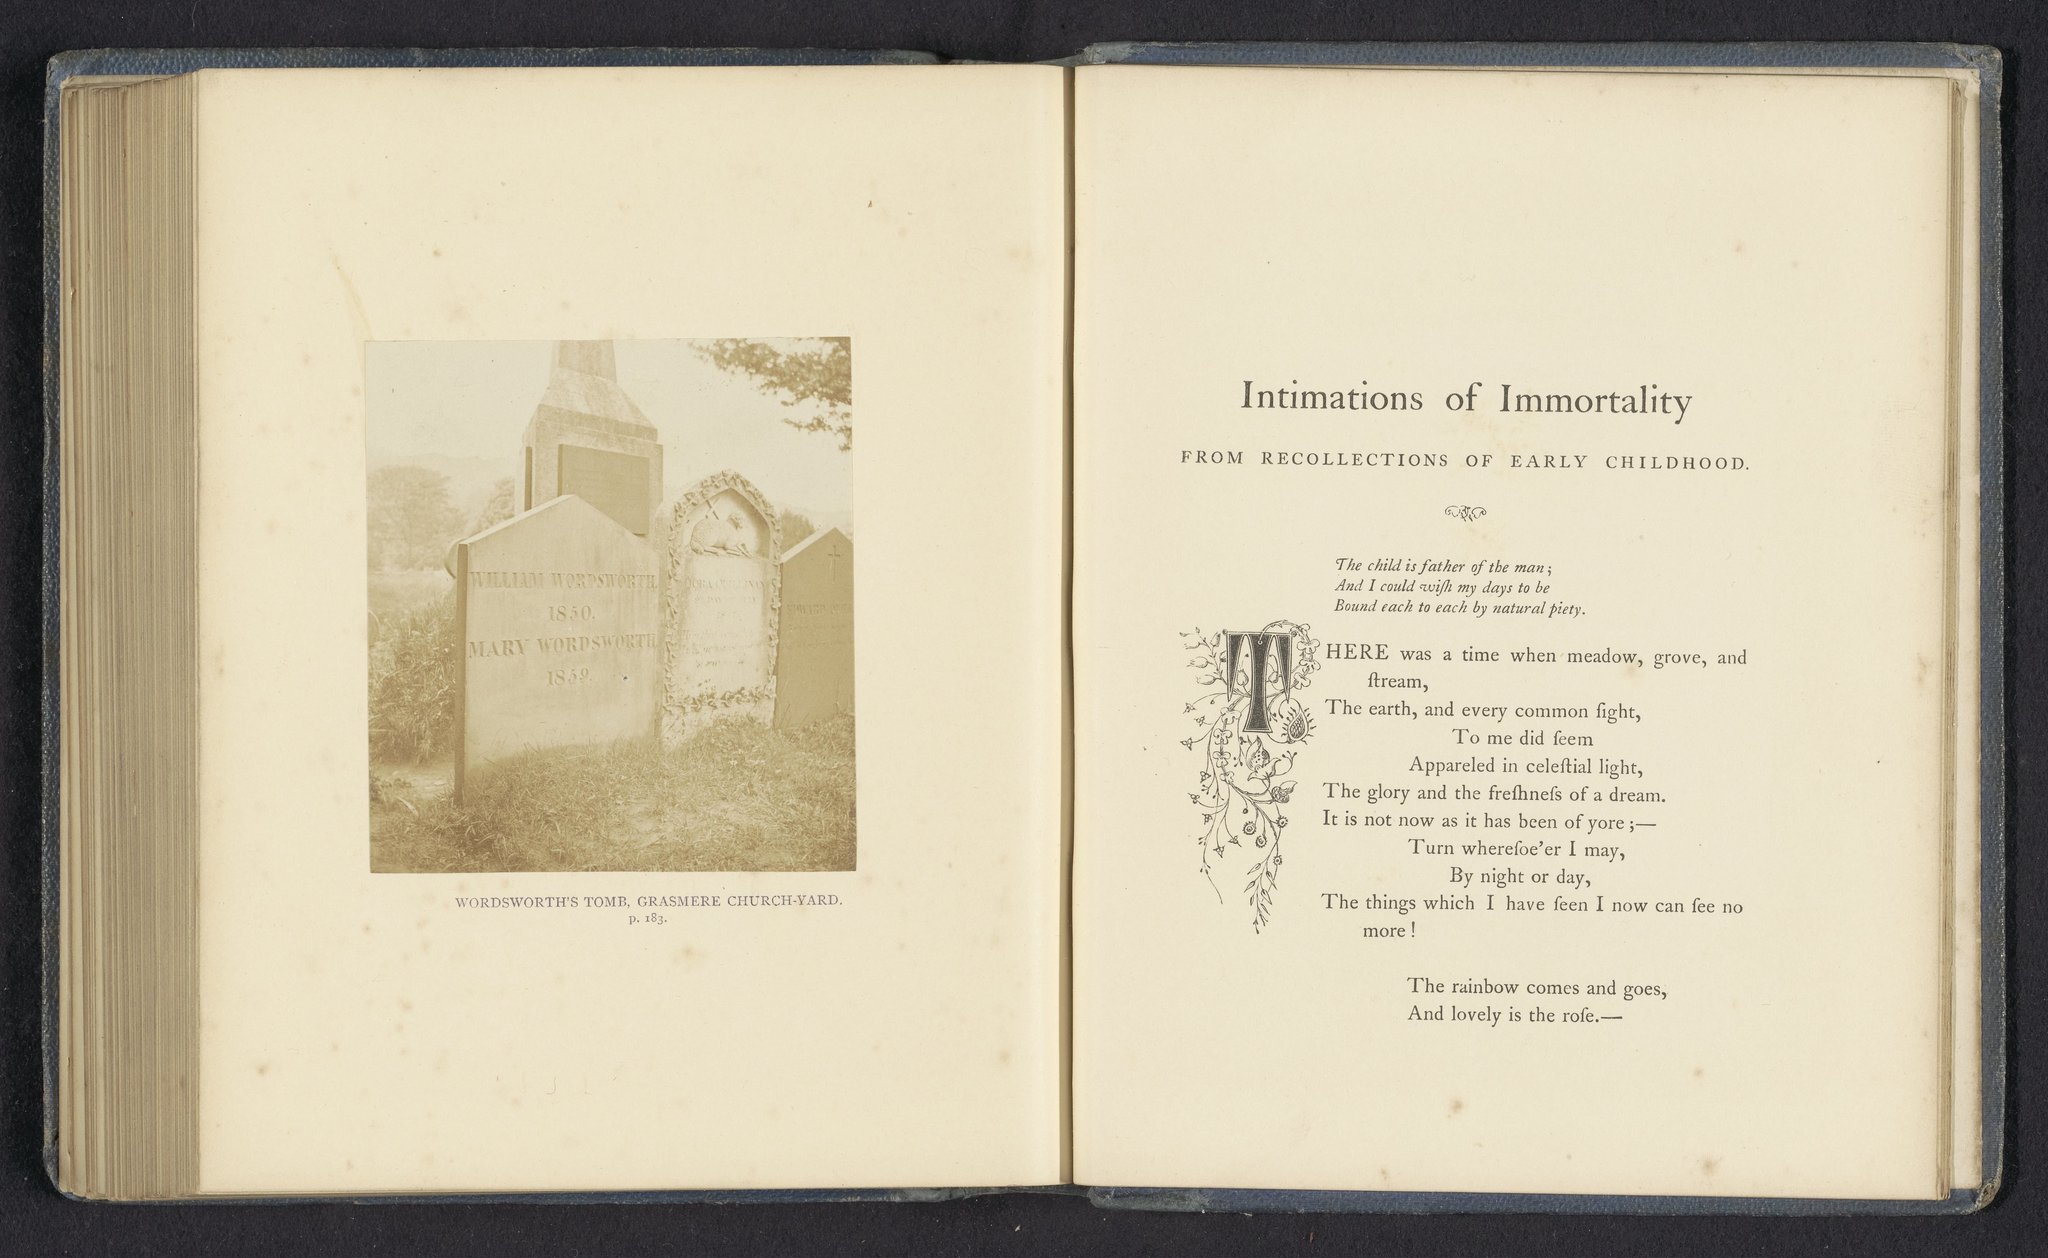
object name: page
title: Wordworth's tomb, Grasmere church-yard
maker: thomas ogle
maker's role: fotograaf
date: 1854-1864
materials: photographic support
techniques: albumen print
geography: grasmere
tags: grave, tomb, churchyard (around church)